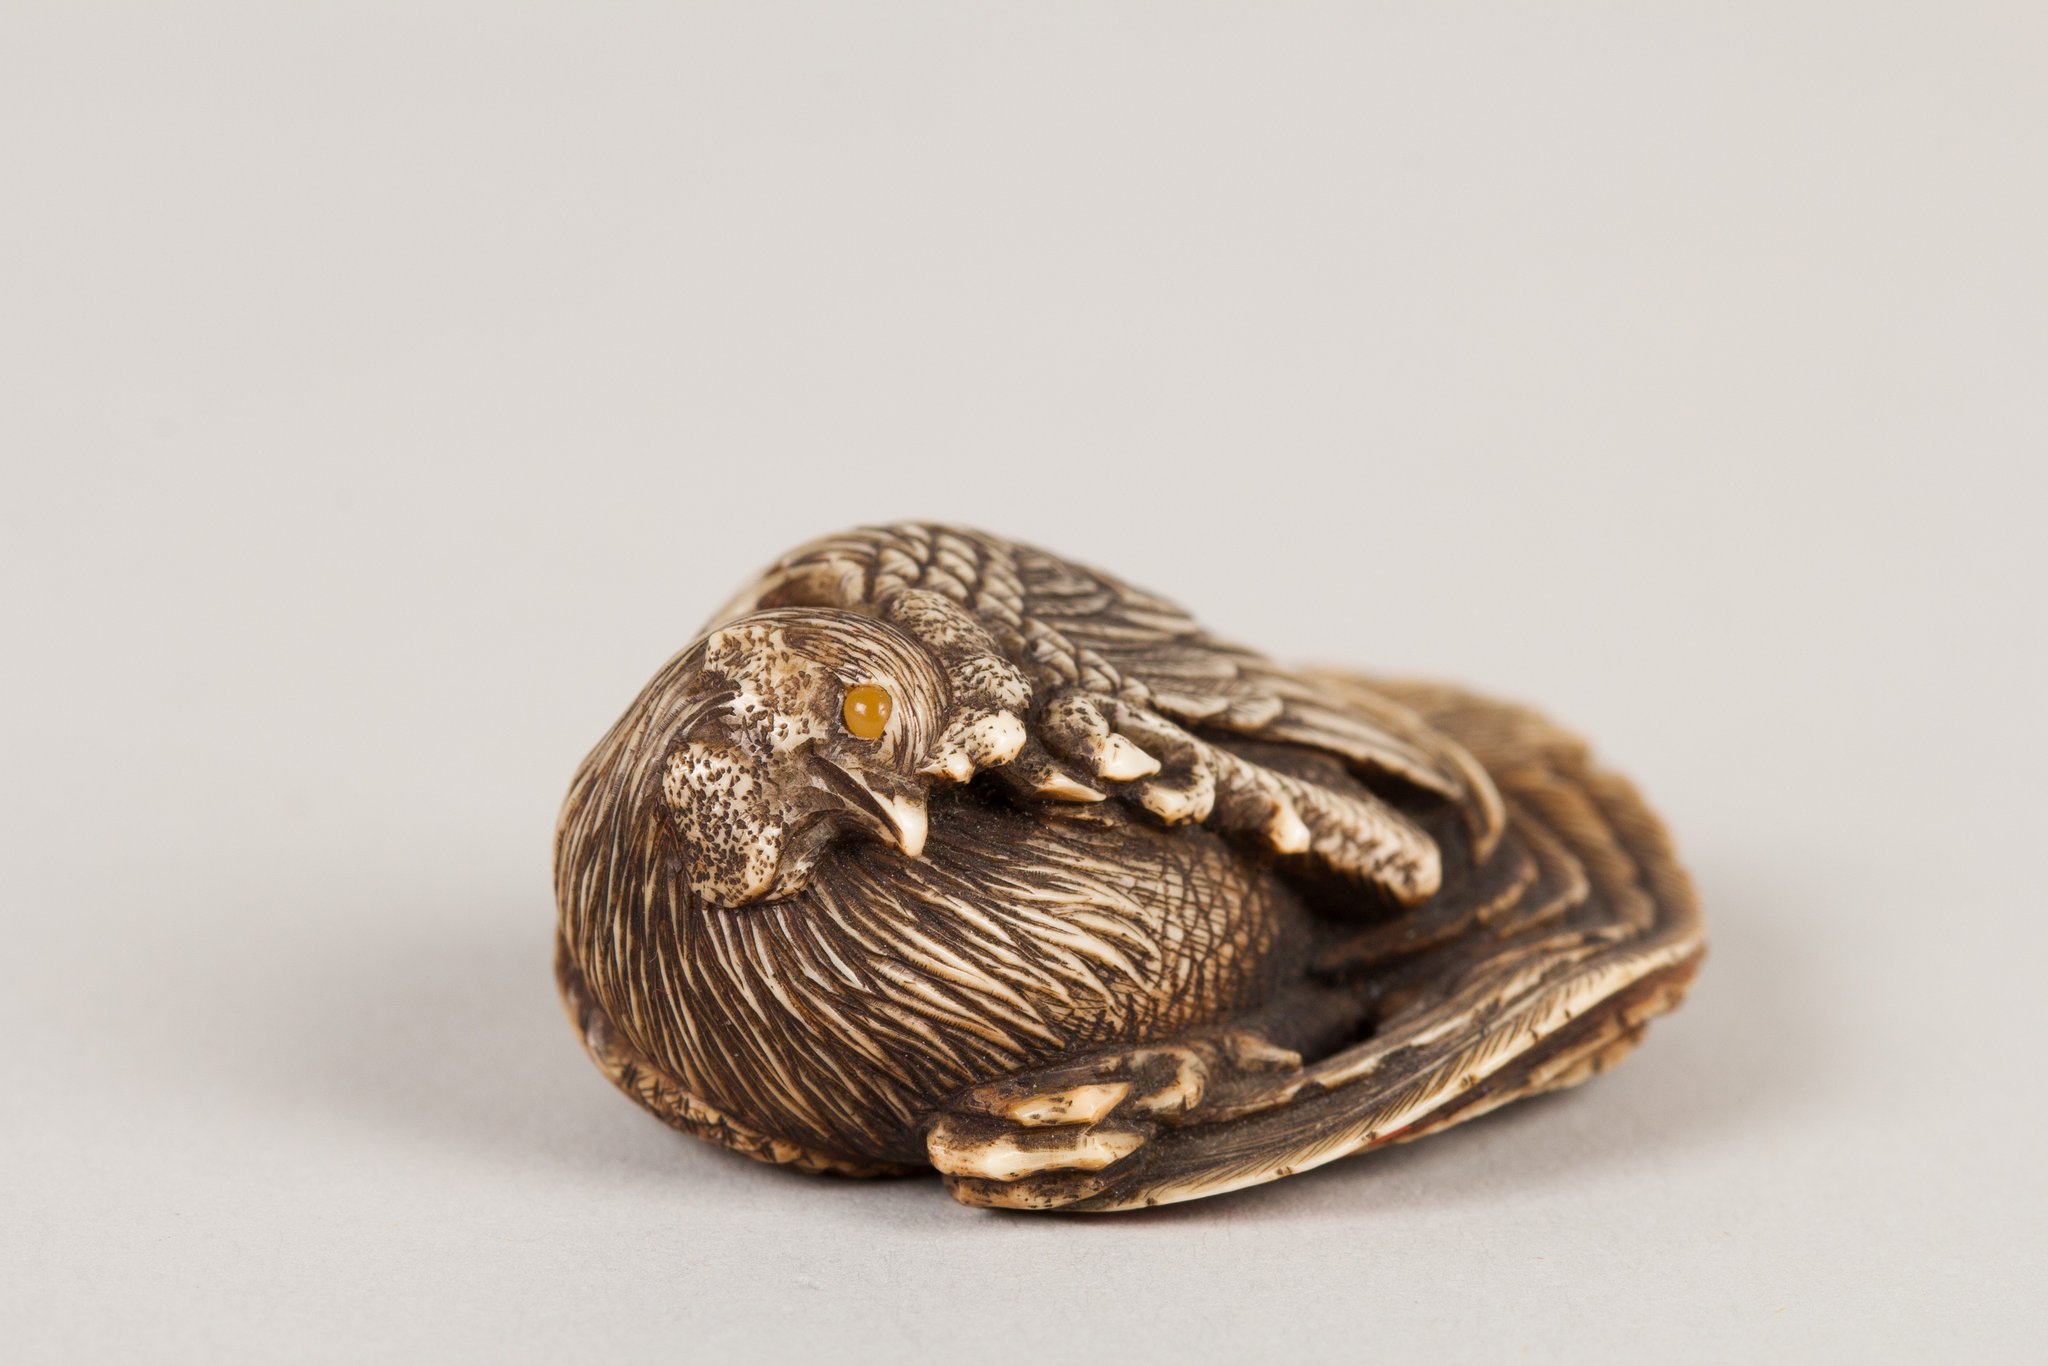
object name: netsuke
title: Netsuke of Chicken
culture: japanese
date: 1801-1900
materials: bone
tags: chickens